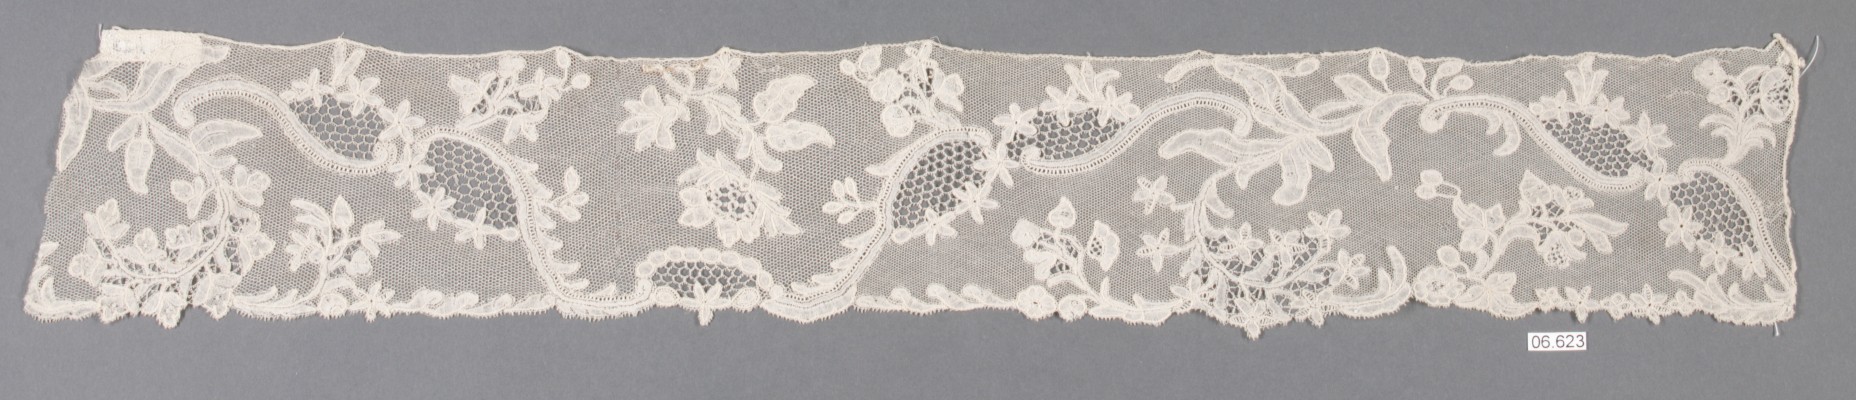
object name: strip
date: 1701-1800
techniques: lace